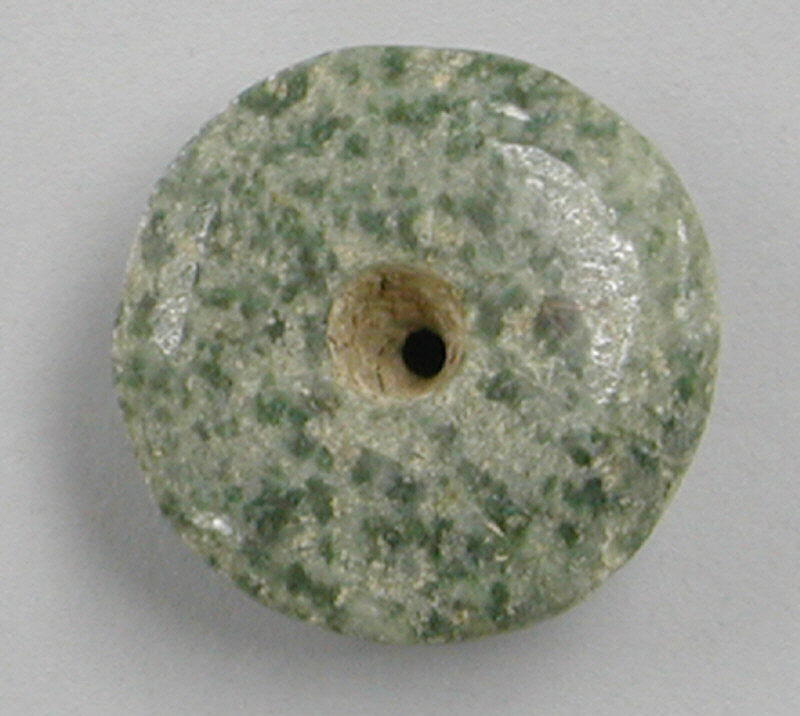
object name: earflare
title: Stone Earflare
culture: mexican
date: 1501-1600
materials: stone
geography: mexico